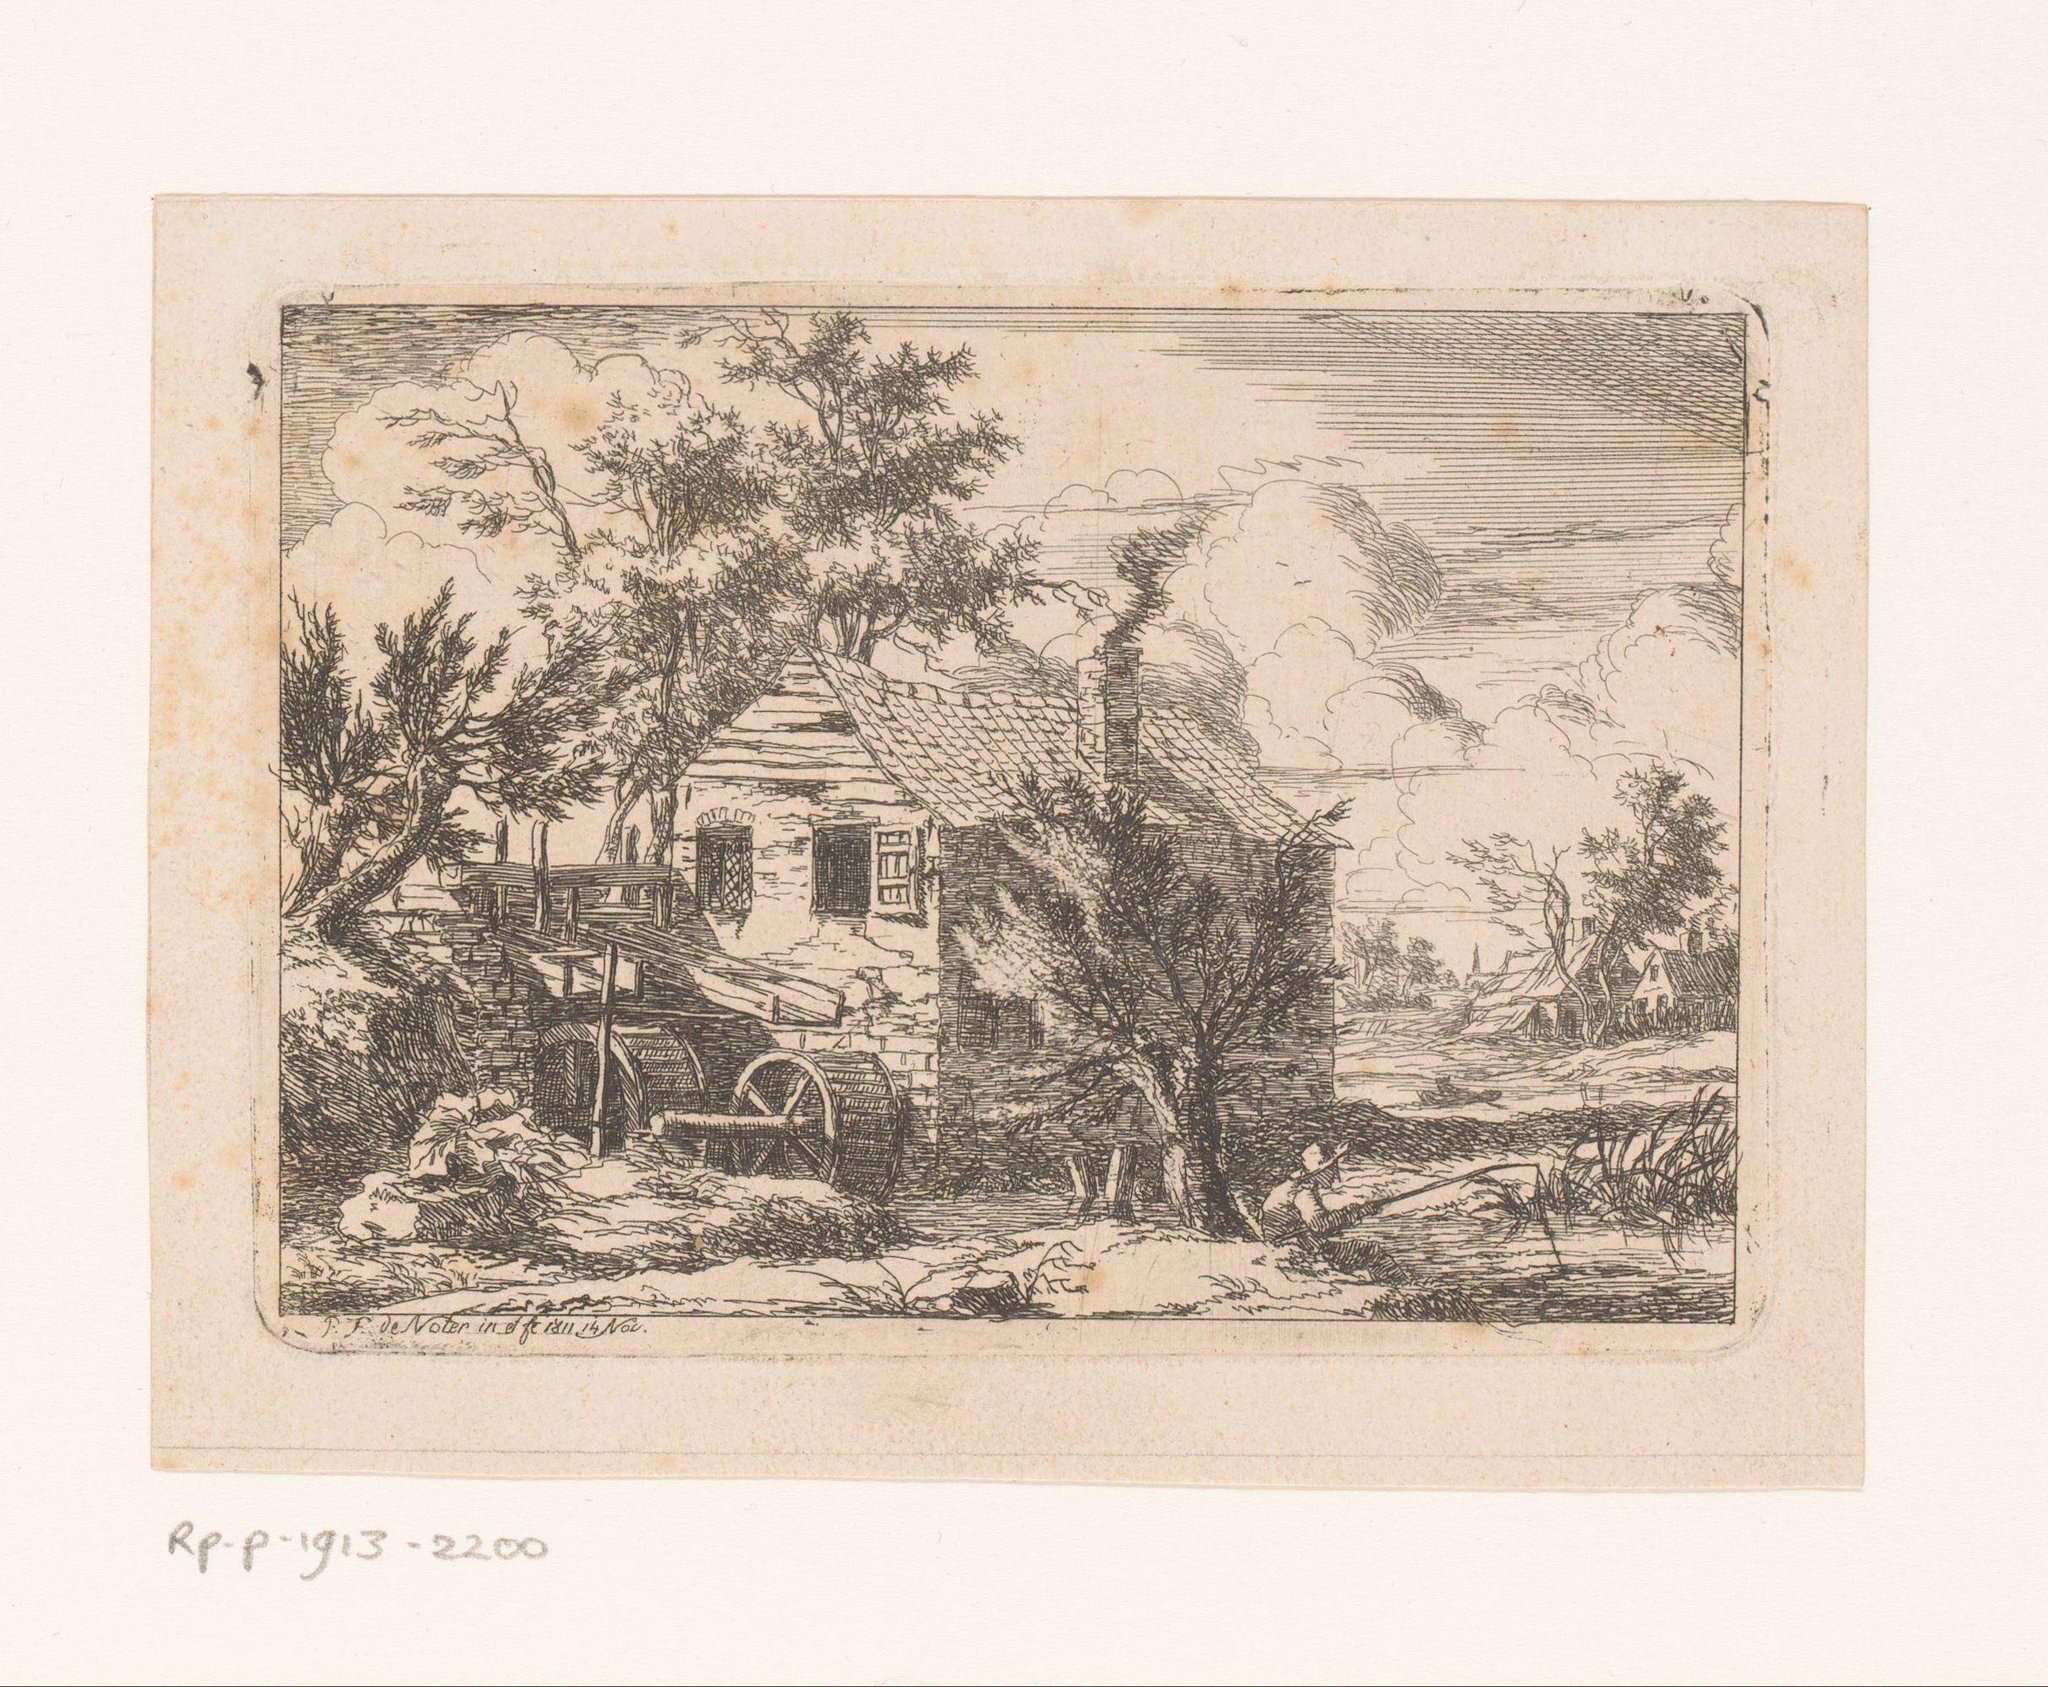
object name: print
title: Landschap met watermolen en een visser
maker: pierre françois de noter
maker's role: painter, print maker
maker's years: 1779-1843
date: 1811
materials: paper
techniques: etching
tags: watermill in landscape (+ city(-scape) with figures, staffage), angling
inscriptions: collector's mark: Lugt 2228, collector's mark: Lugt 1485